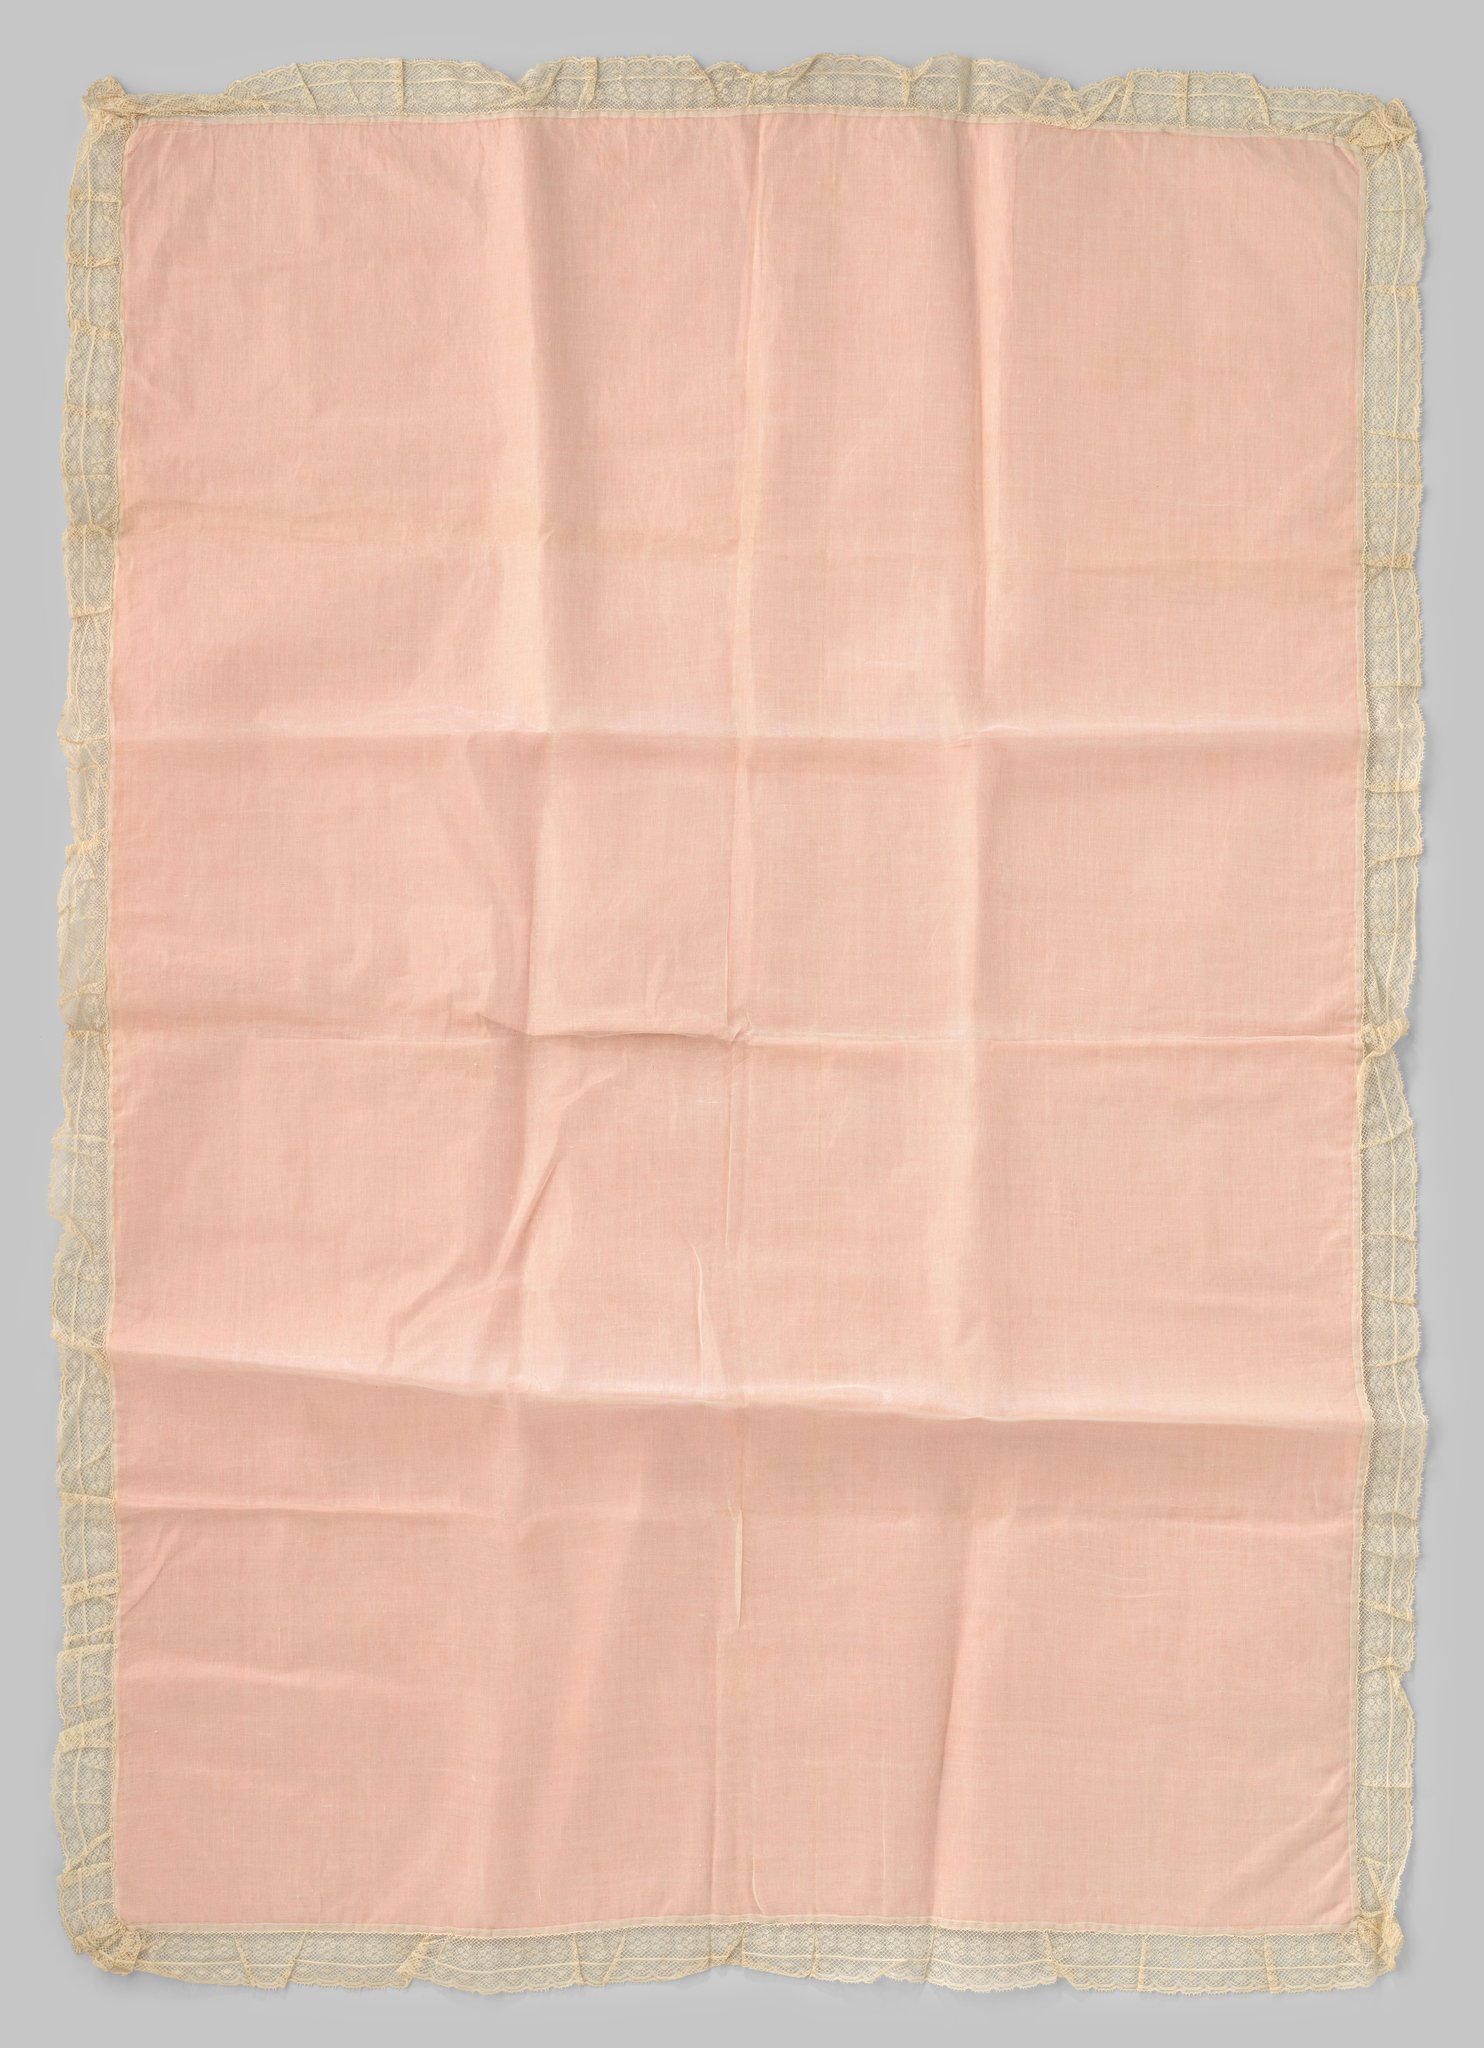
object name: kleed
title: Rechthoekig kleed, van roze textiel, met aan één kant een overtrek van kant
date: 1836-1898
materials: textile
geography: netherlands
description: Rechthoekig kleed, van roze textiel, met aan één kant een overtrek van kant.